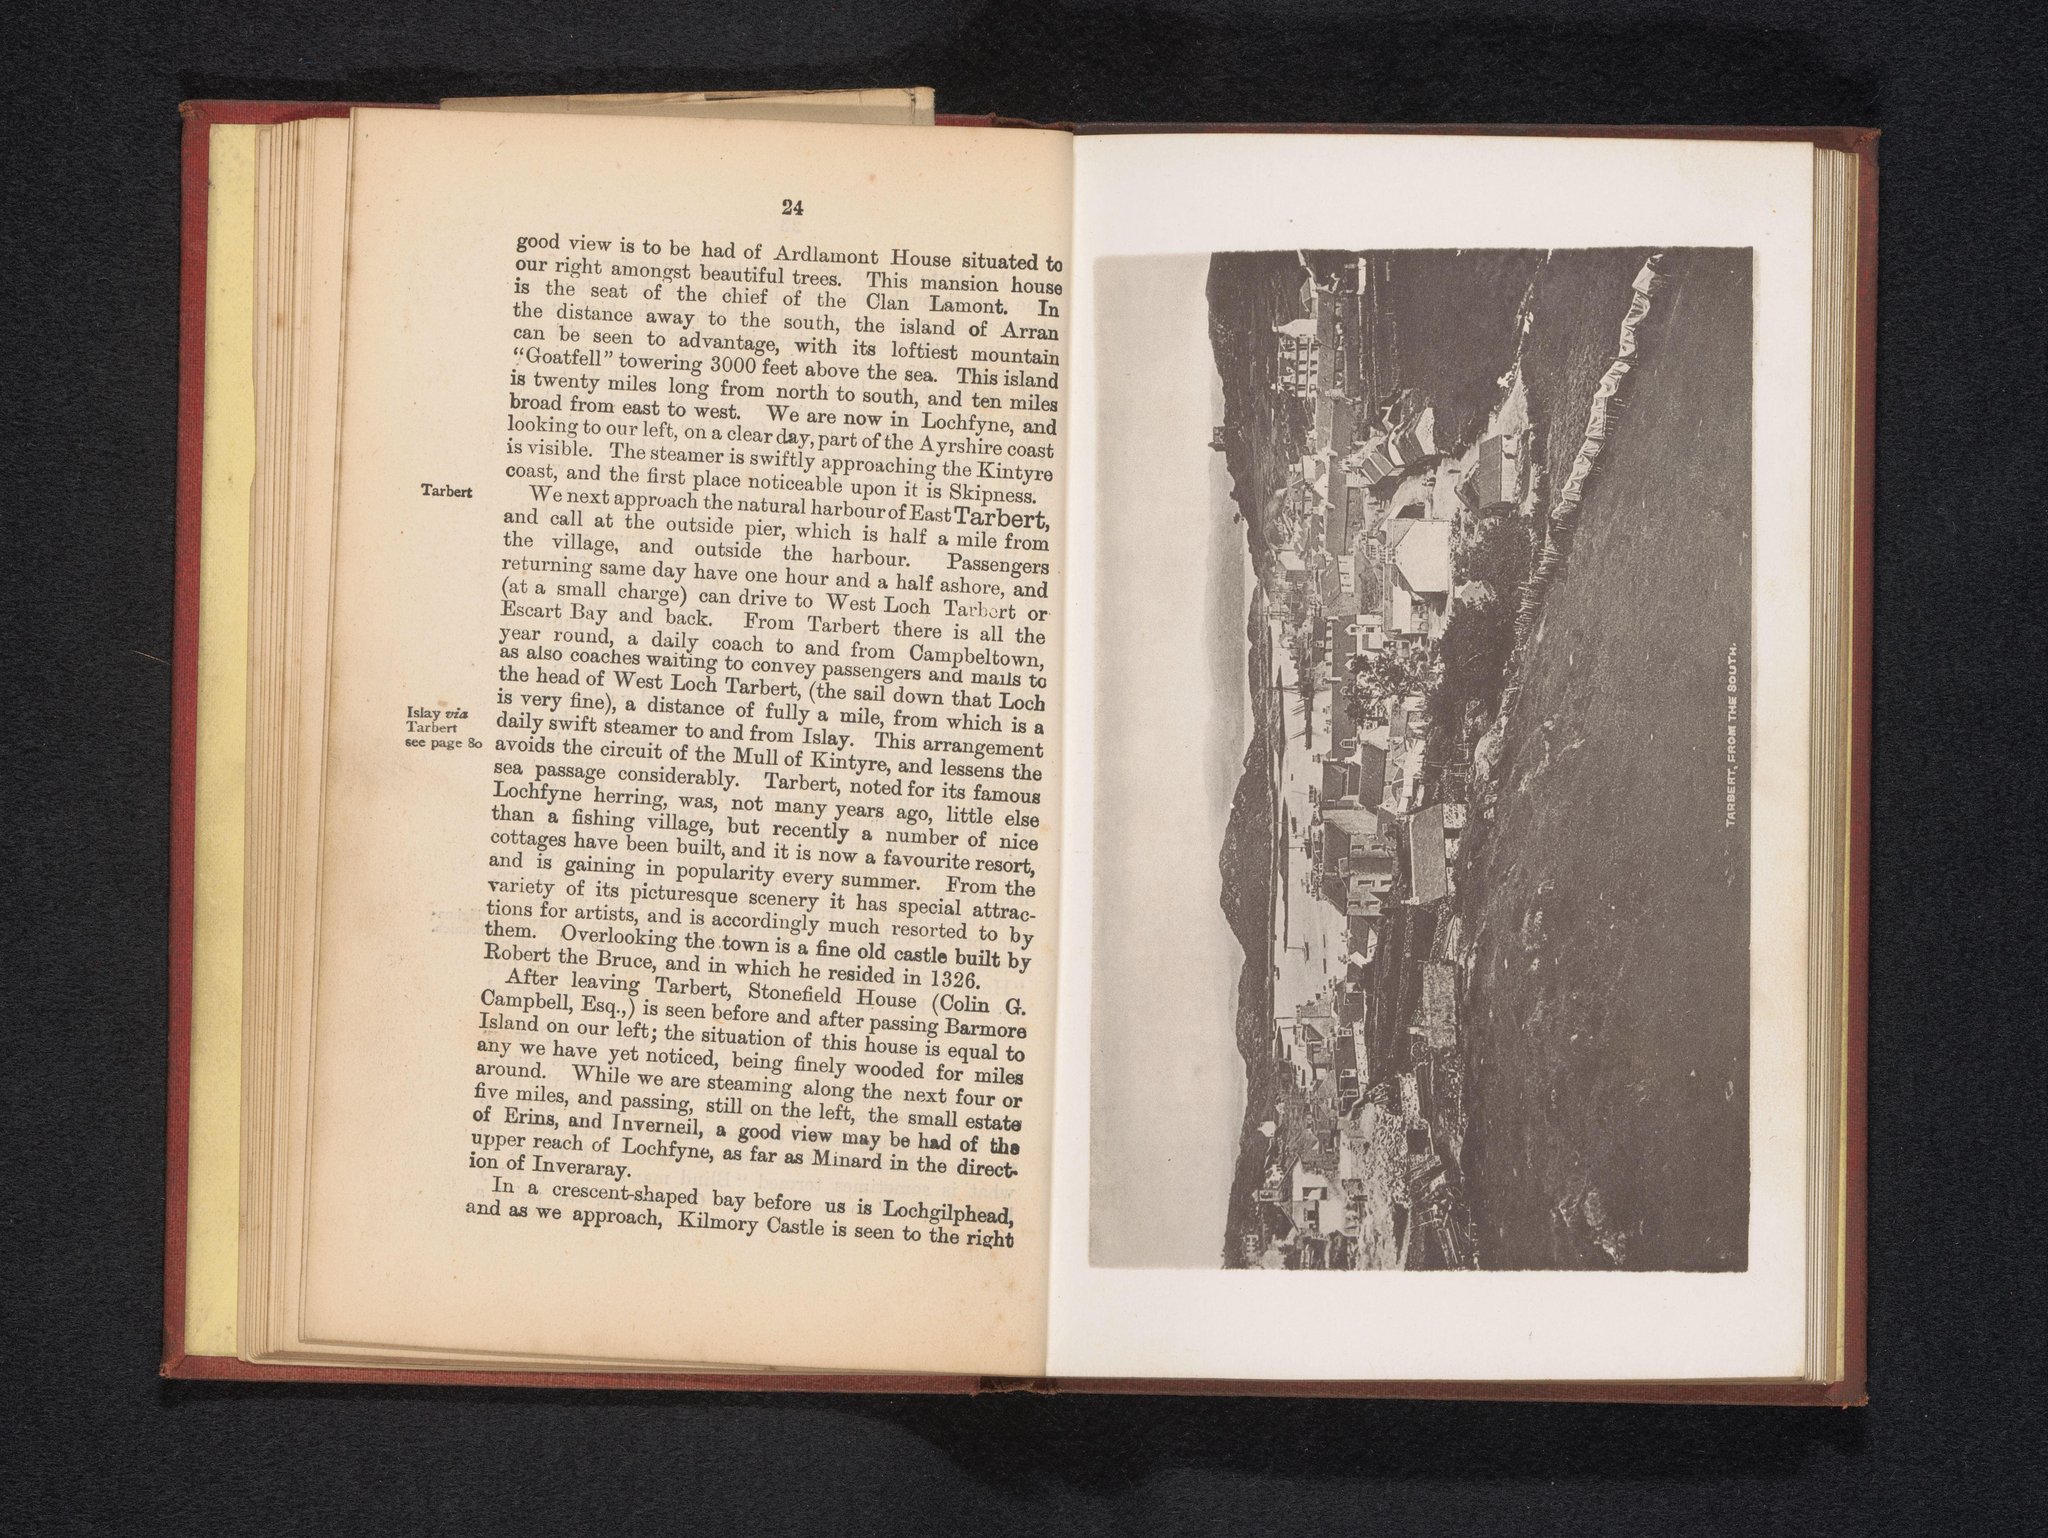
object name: photomechanical print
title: Gezicht op Tarbert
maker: Anonymous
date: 1881-1886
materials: paper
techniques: photograph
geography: tarbert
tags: city-view in general; 'veduta'